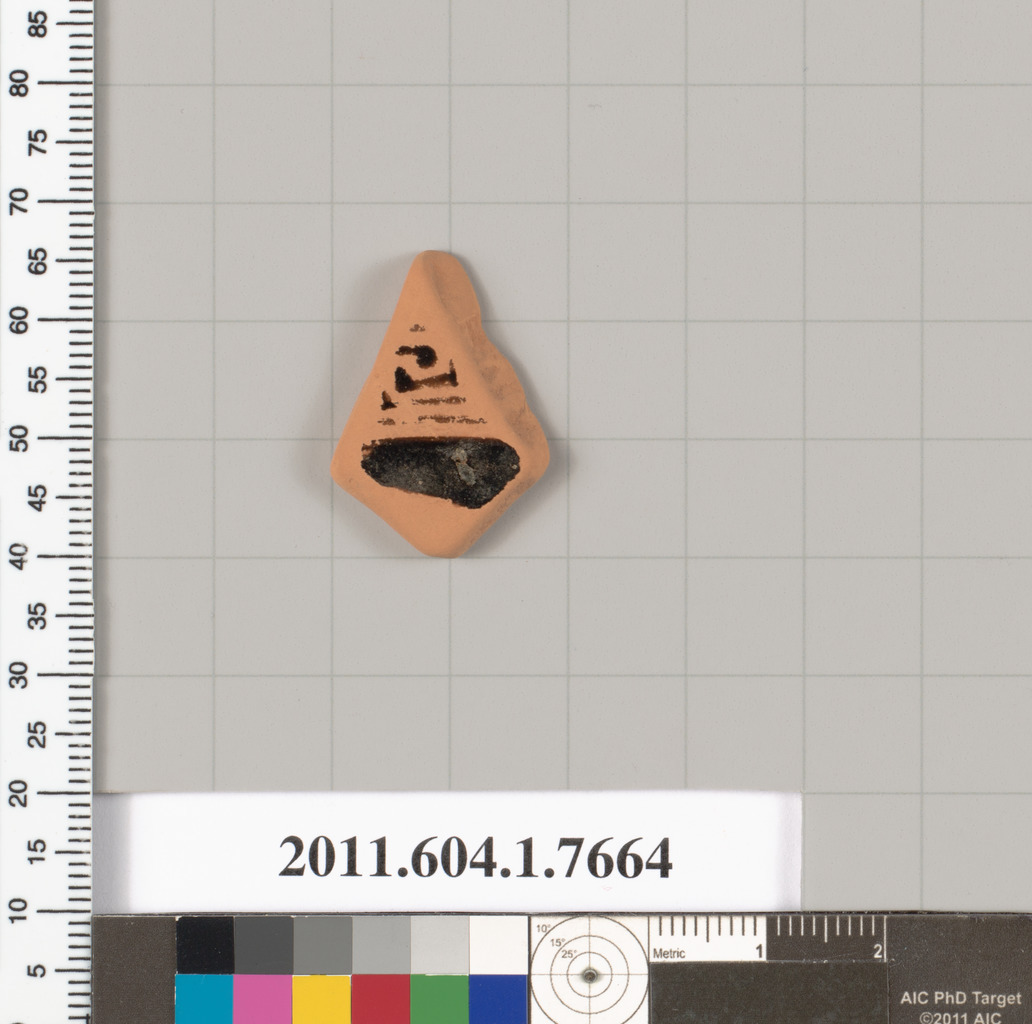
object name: kylix fragment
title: Terracotta fragment of a kylix (drinking cup)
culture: greek, attic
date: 460-450 BCE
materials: terracotta